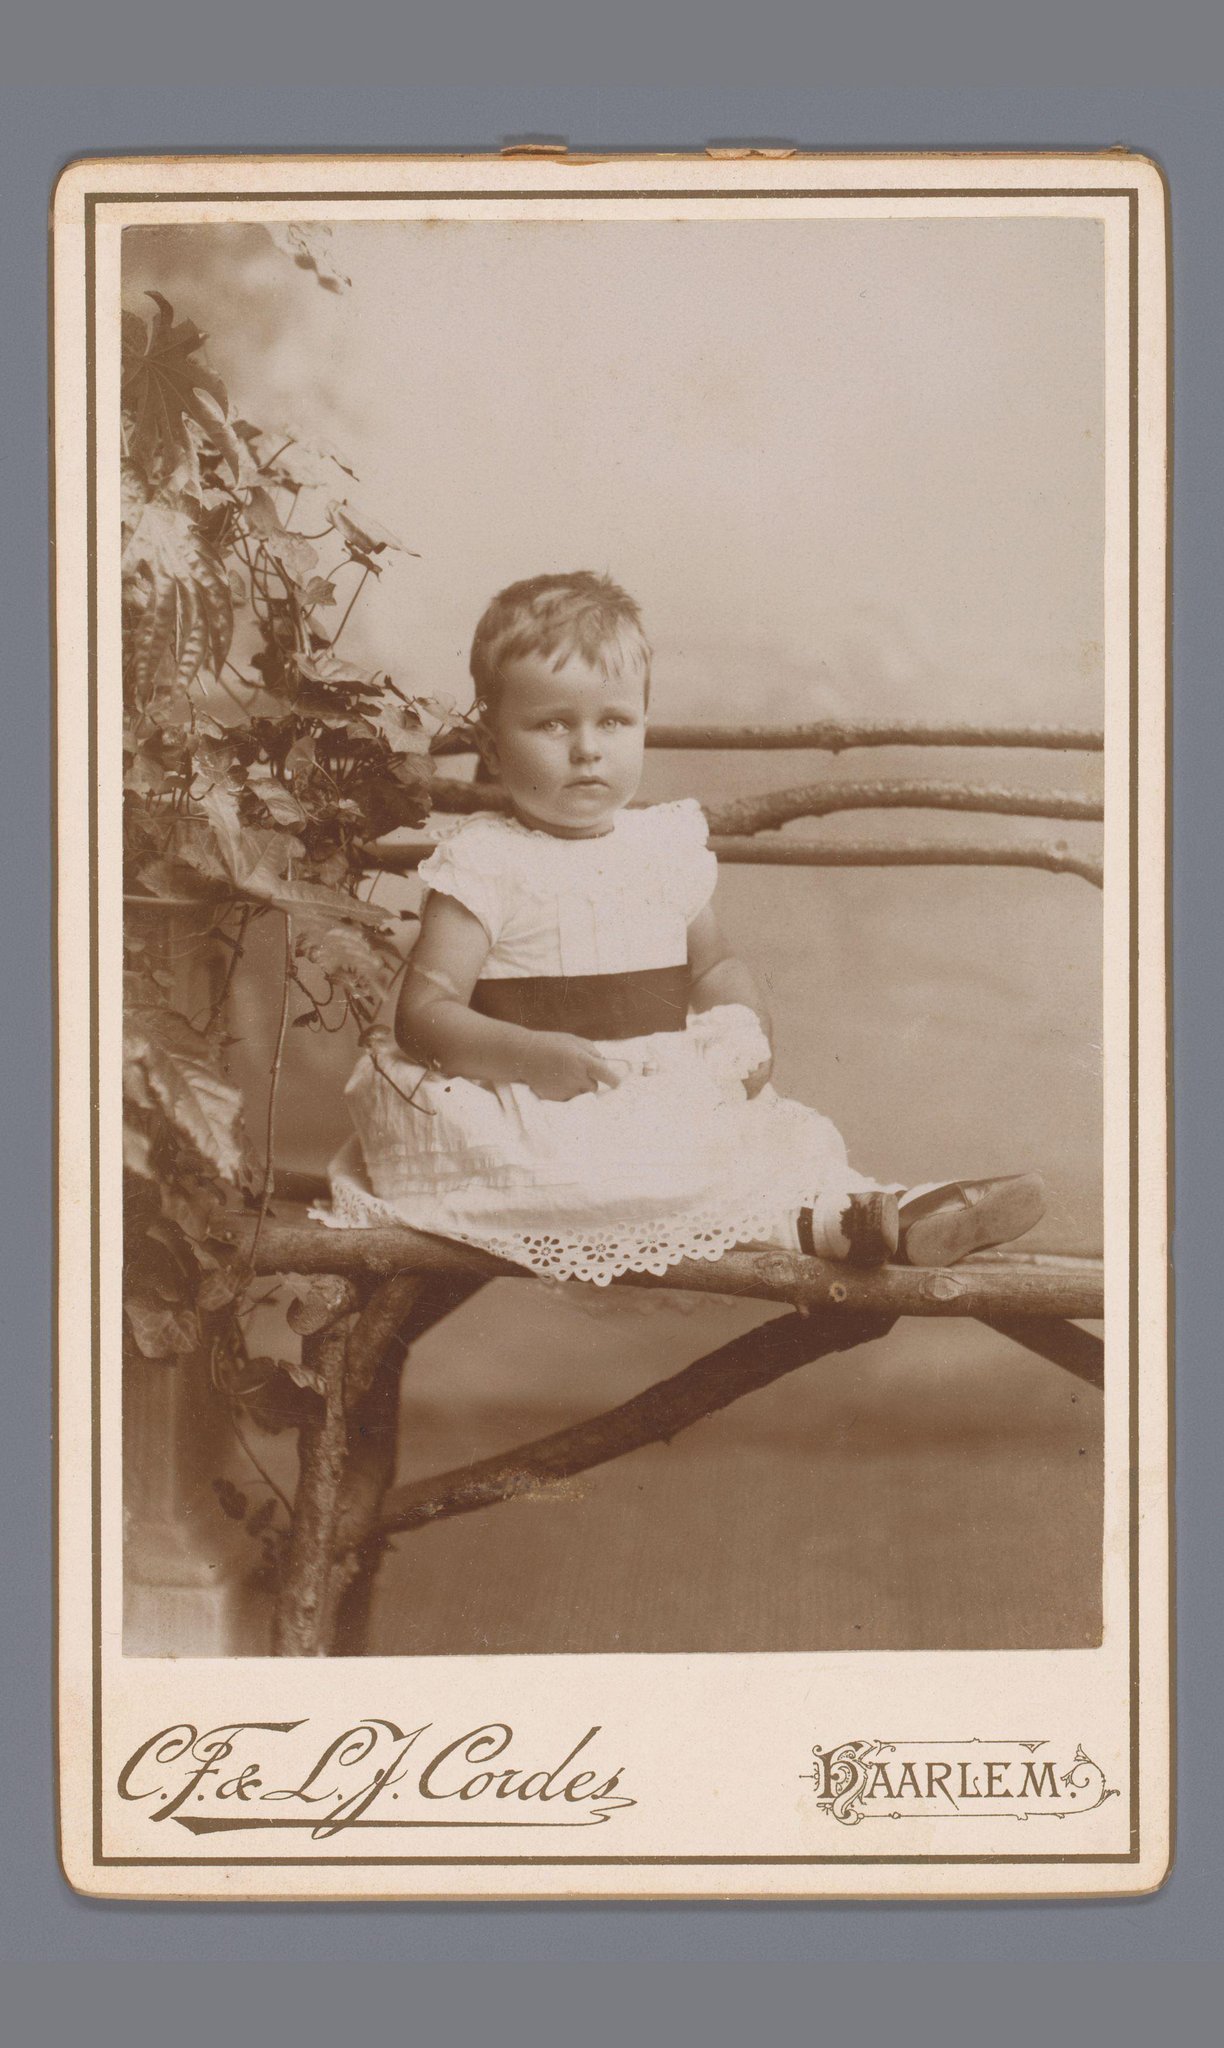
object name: photograph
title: Portret van Johanna Geertruida Jonker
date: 1895-1900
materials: cardboard, photographic support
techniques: collodion silver print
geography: haarlem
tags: historical persons, haarlem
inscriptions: workshop stamp: ‘C.F. & L.J. Cordes/ Haarlem, Groote Houtstraat 84/ 's Bosch a/d. Parade’